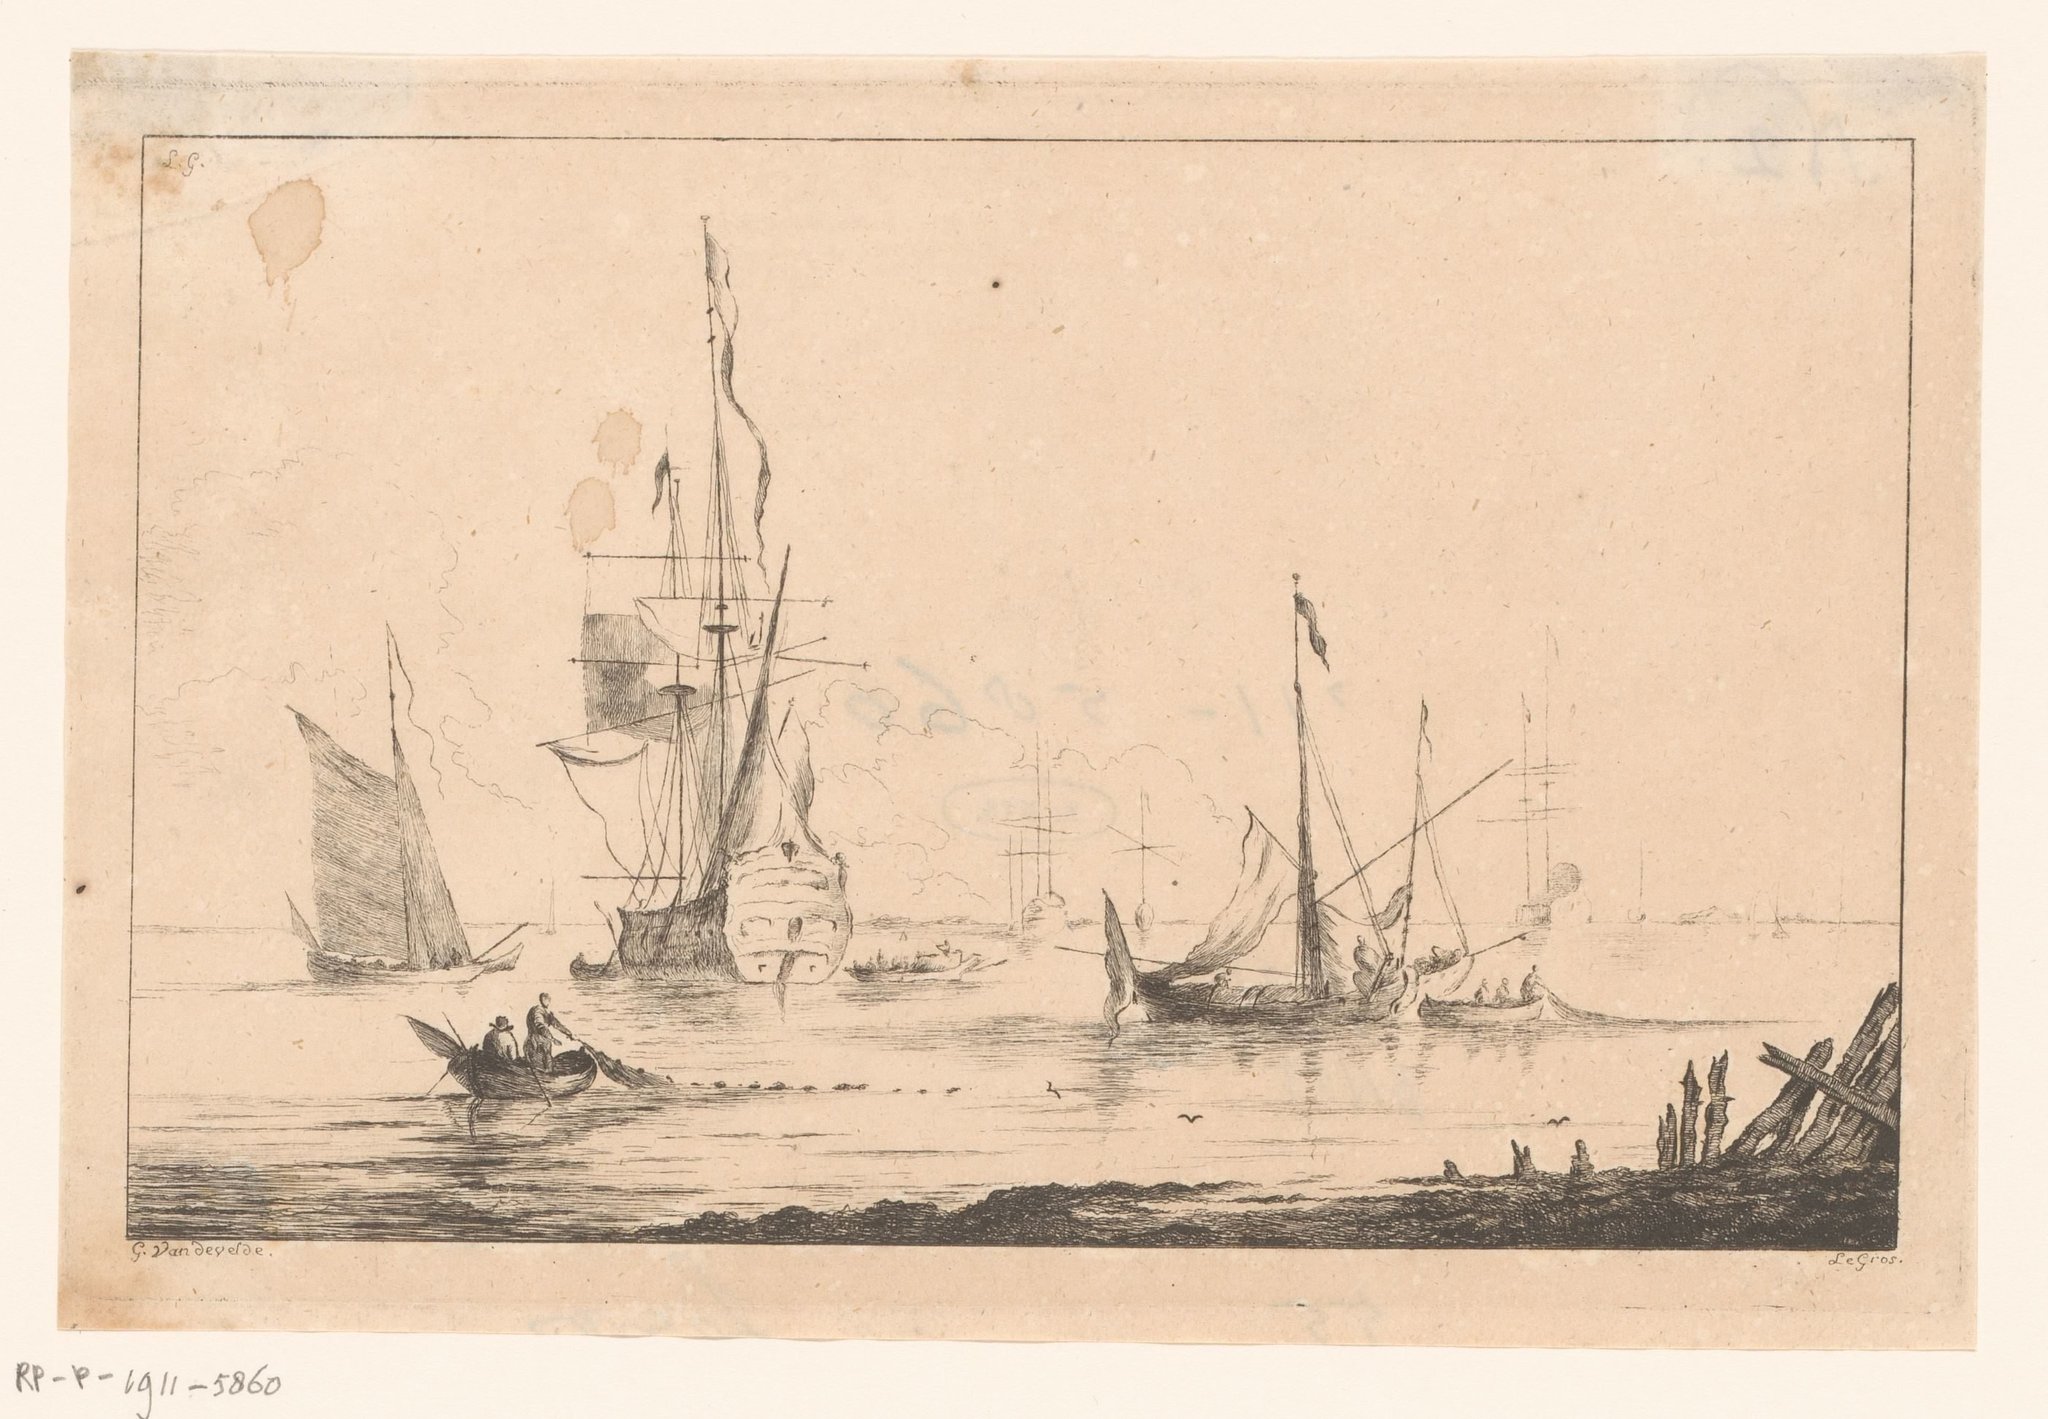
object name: print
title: Schepen en boten aan de kust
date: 1764-1834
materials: paper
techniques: etching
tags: ship bound for the harbour, traffic on the water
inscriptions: collector's mark: Lugt 2228, collector's mark: Lugt 1485